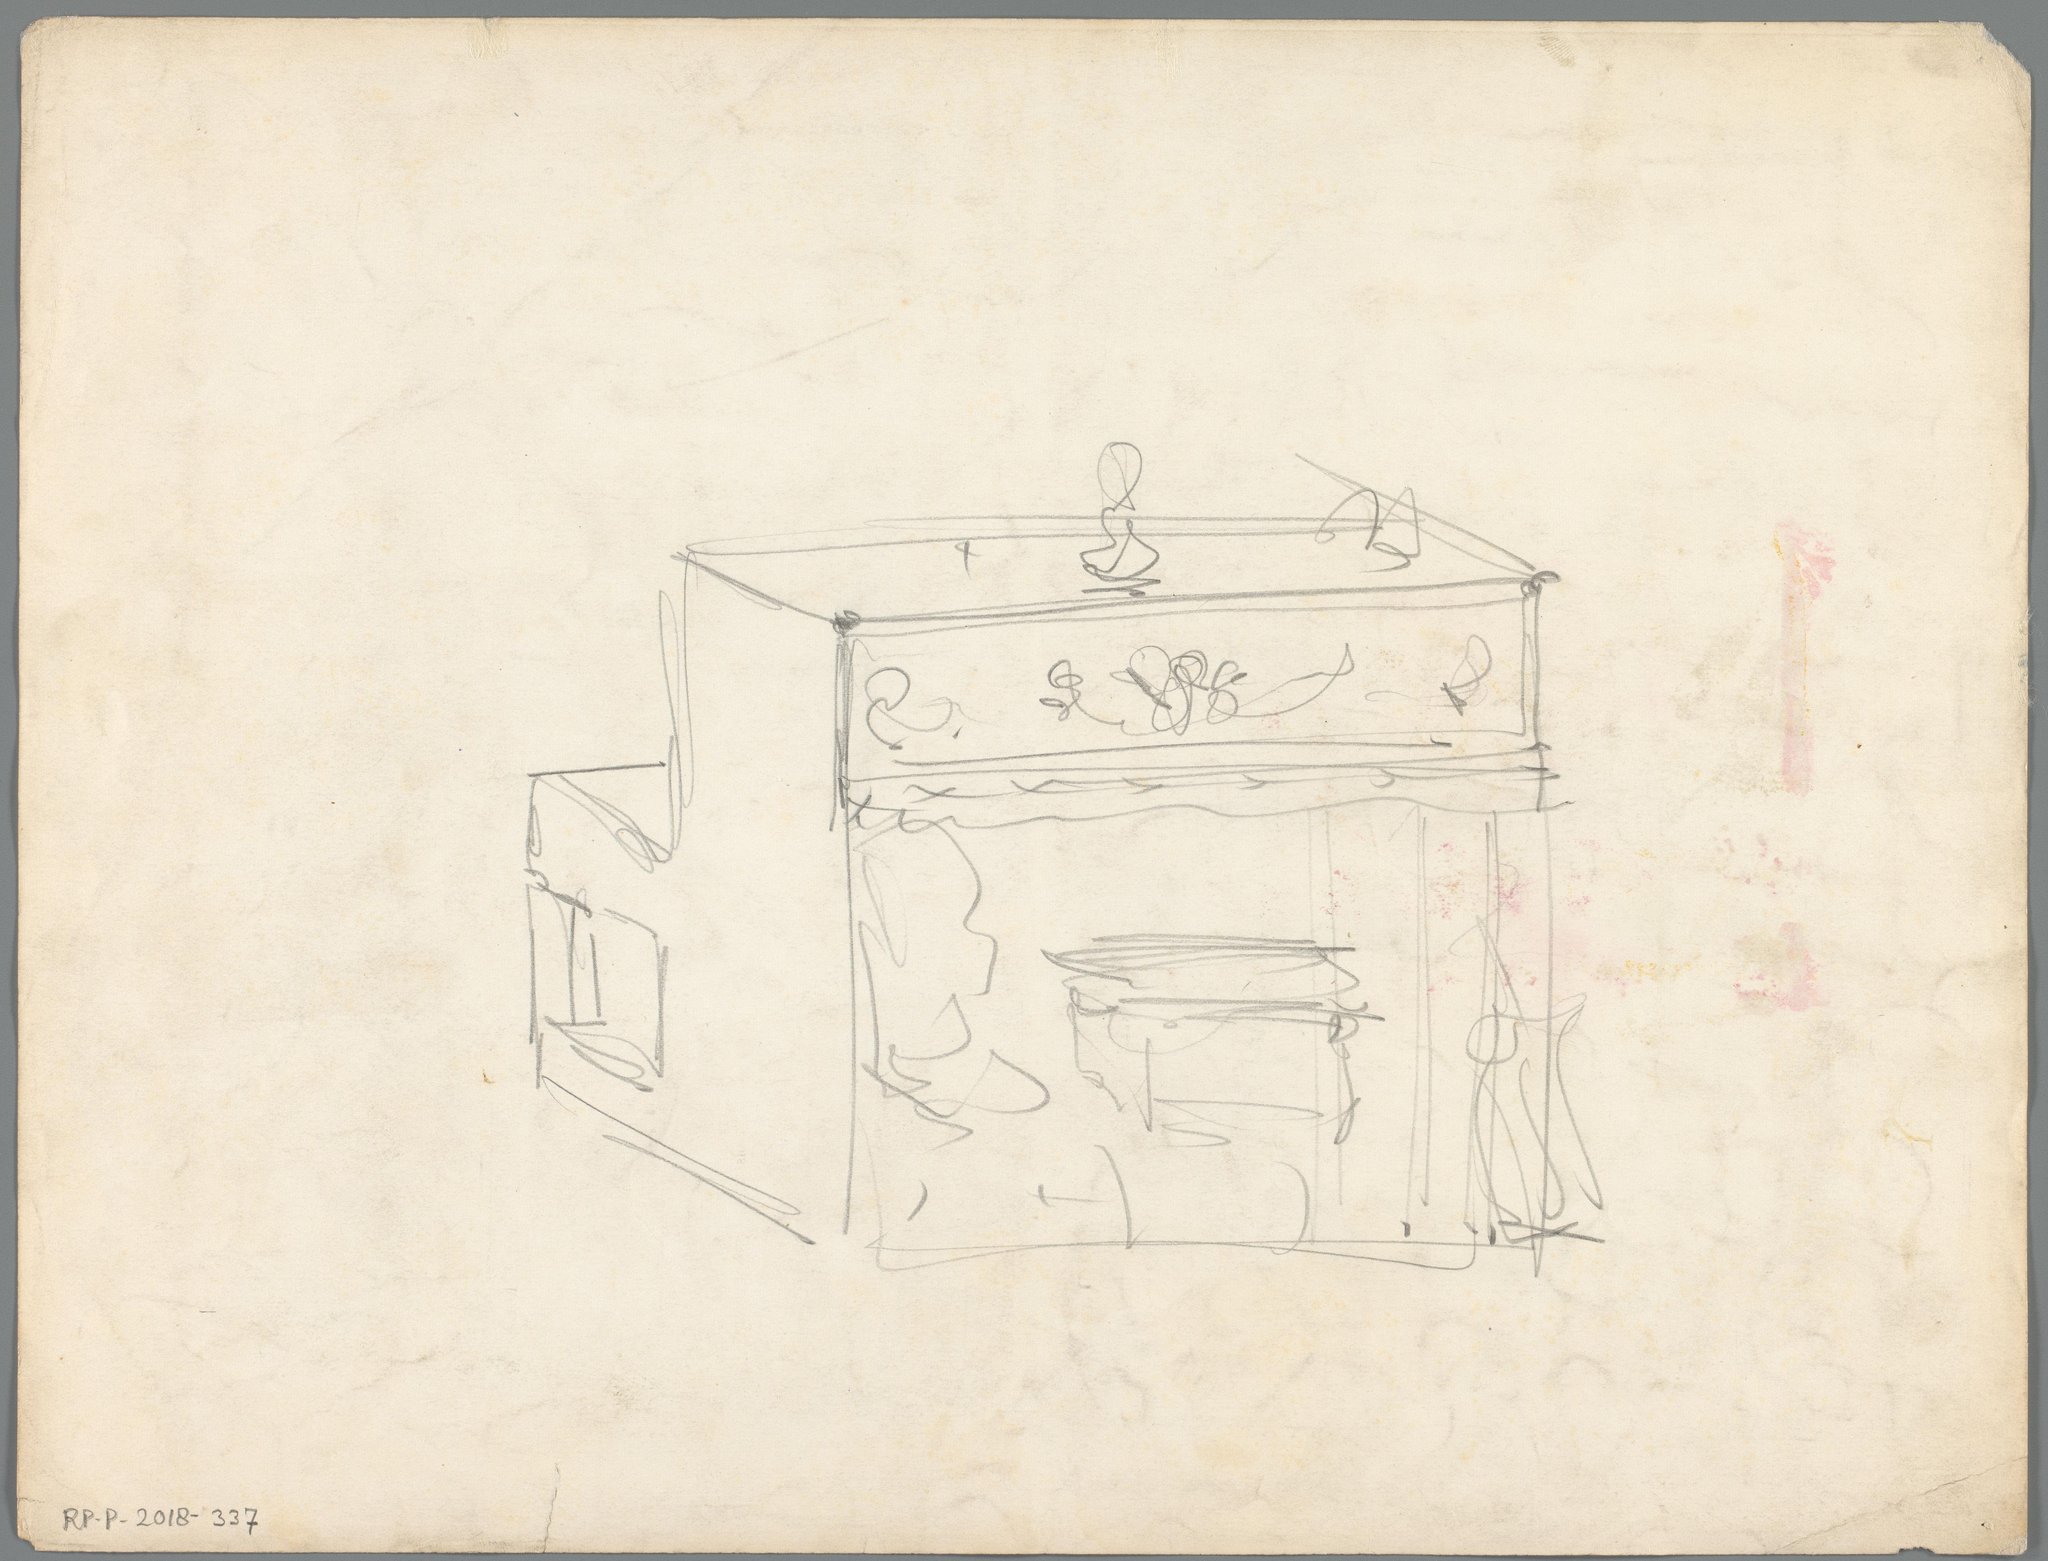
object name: drawing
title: Piano met draperieën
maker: Anonymous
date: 1839-1900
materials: paper, pencil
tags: hangings and drapery, pianoforte